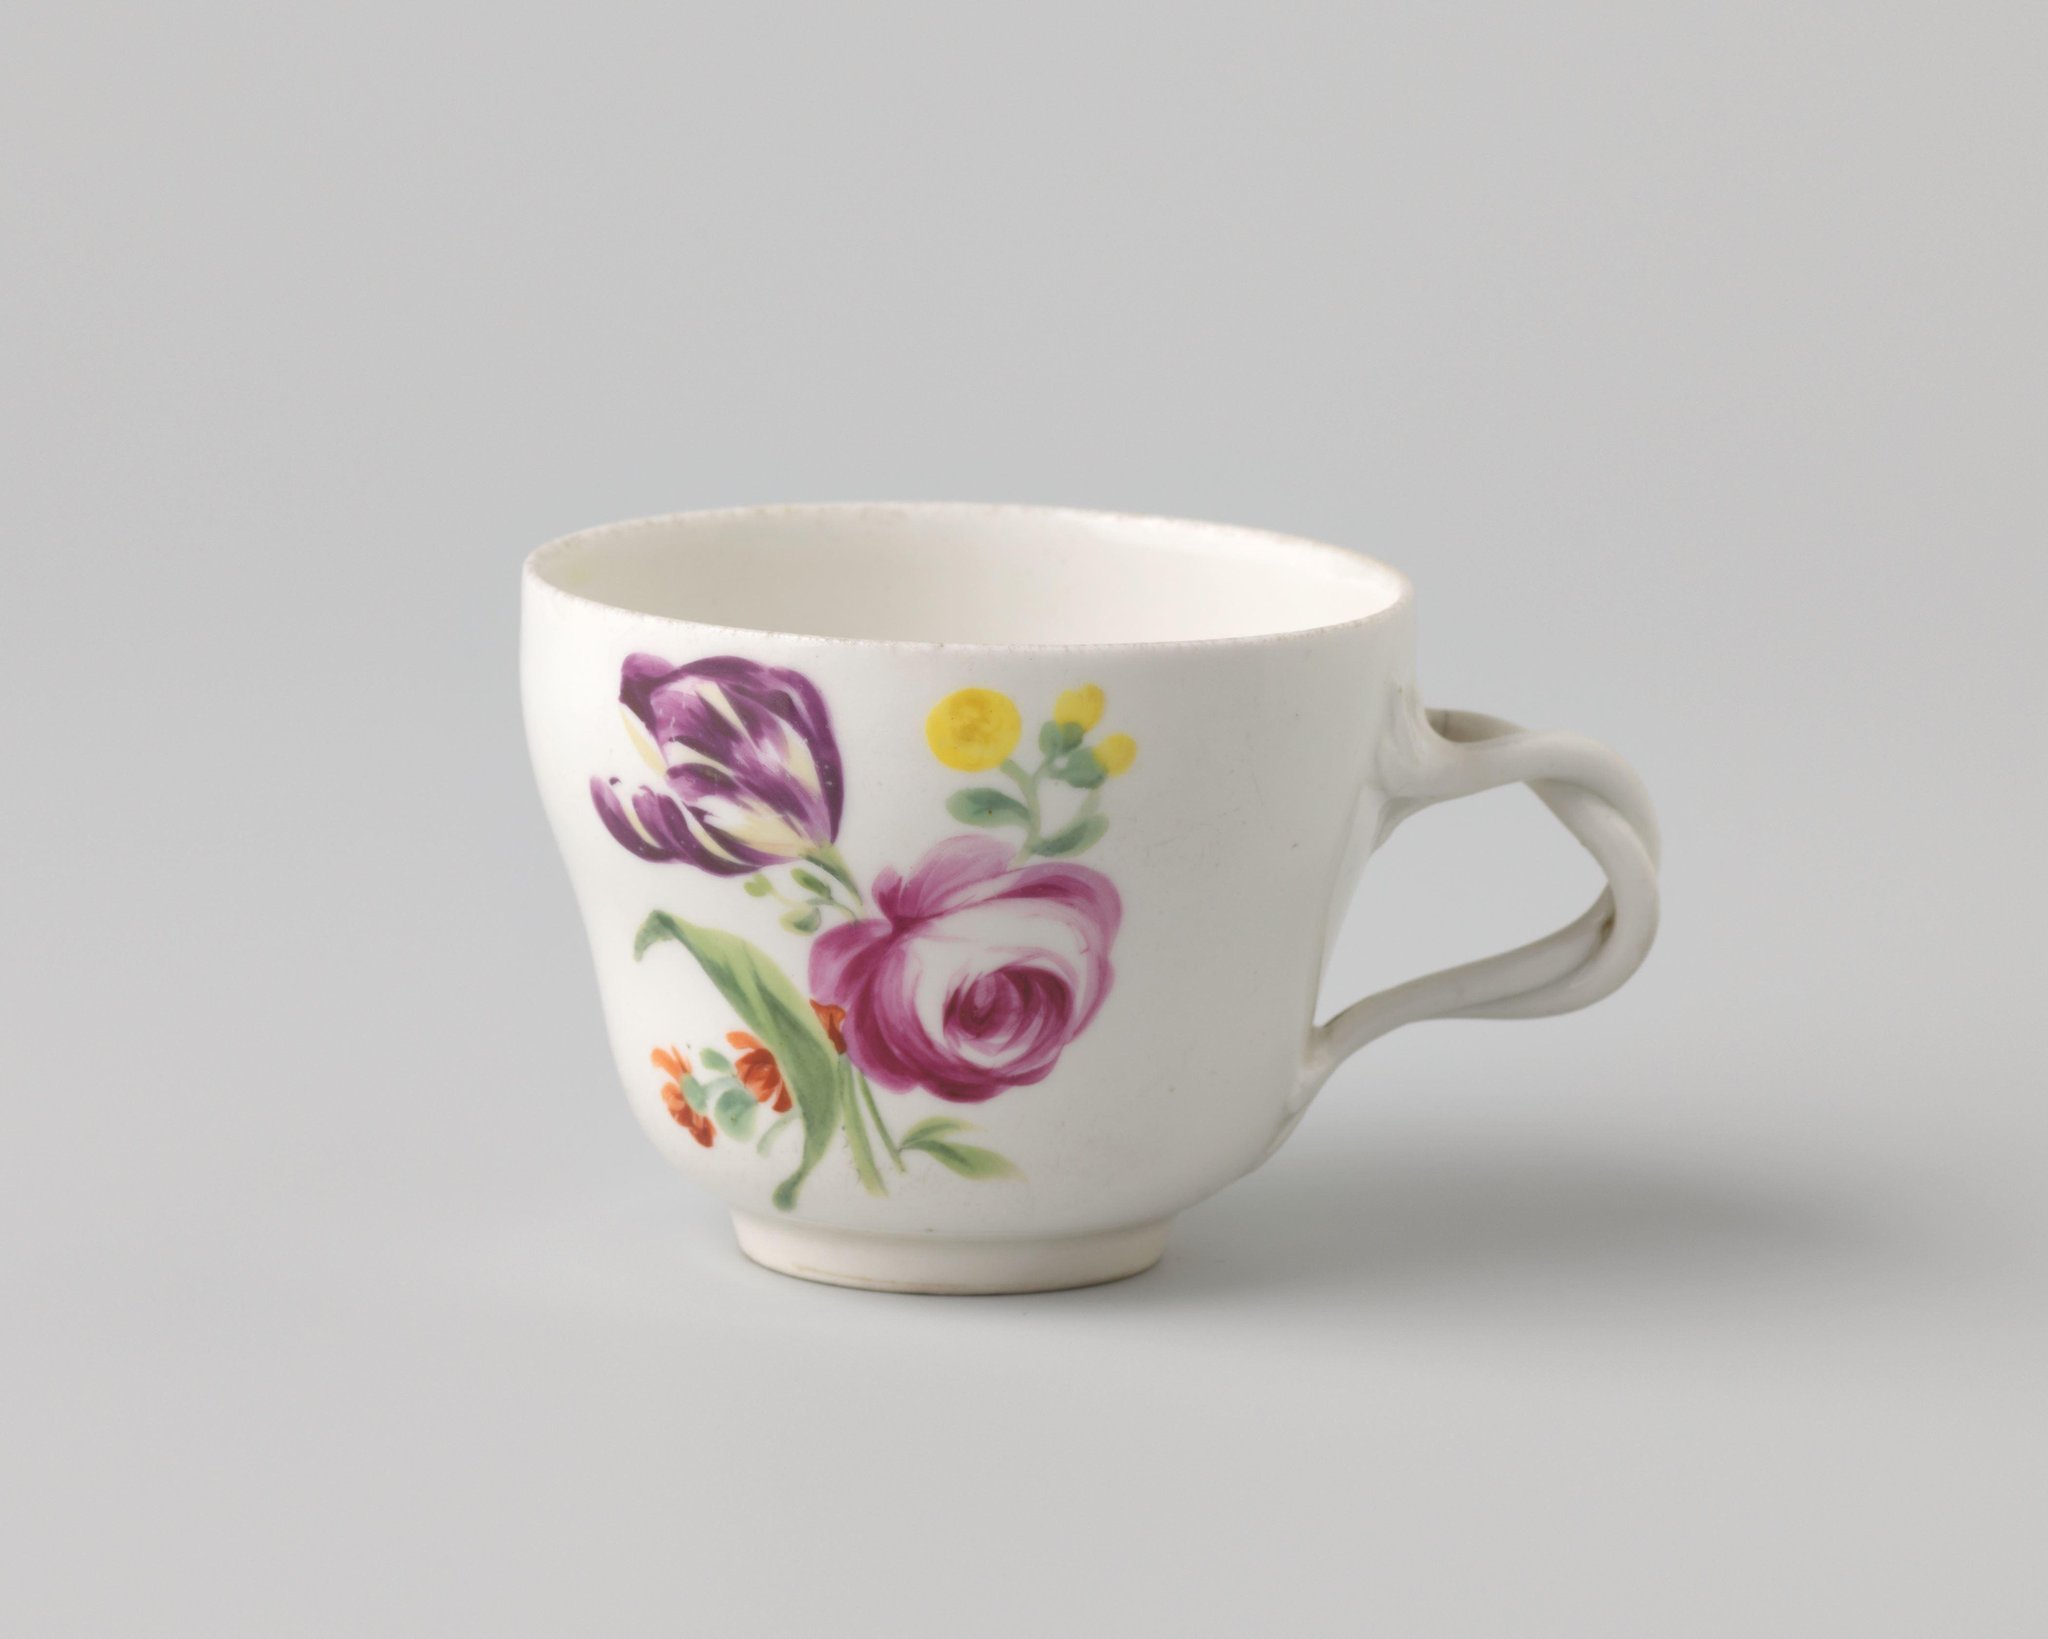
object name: service set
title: Cup with a bouquet and flower sprays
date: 1800-1849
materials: glaze, paint, porcelain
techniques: firing, forming, turning, vitrification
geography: vienna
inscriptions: mark: ‘schild/ 46^/ 12/ 86’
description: Kop, onderdeel van een servies beschilderd met veelkleurige bloemboeketten en strooibloemen. Aan het kopje een oor in de vorm van twee verstrengelde takken. Merken niet voor alle koppen gelijk (bk-1956-63-24/33): o.a. in paars de getallen 83 en 43 en ingegrift de getallen 39 en 800; in onderglazuur blauw een schild met twee dwarsbalken.